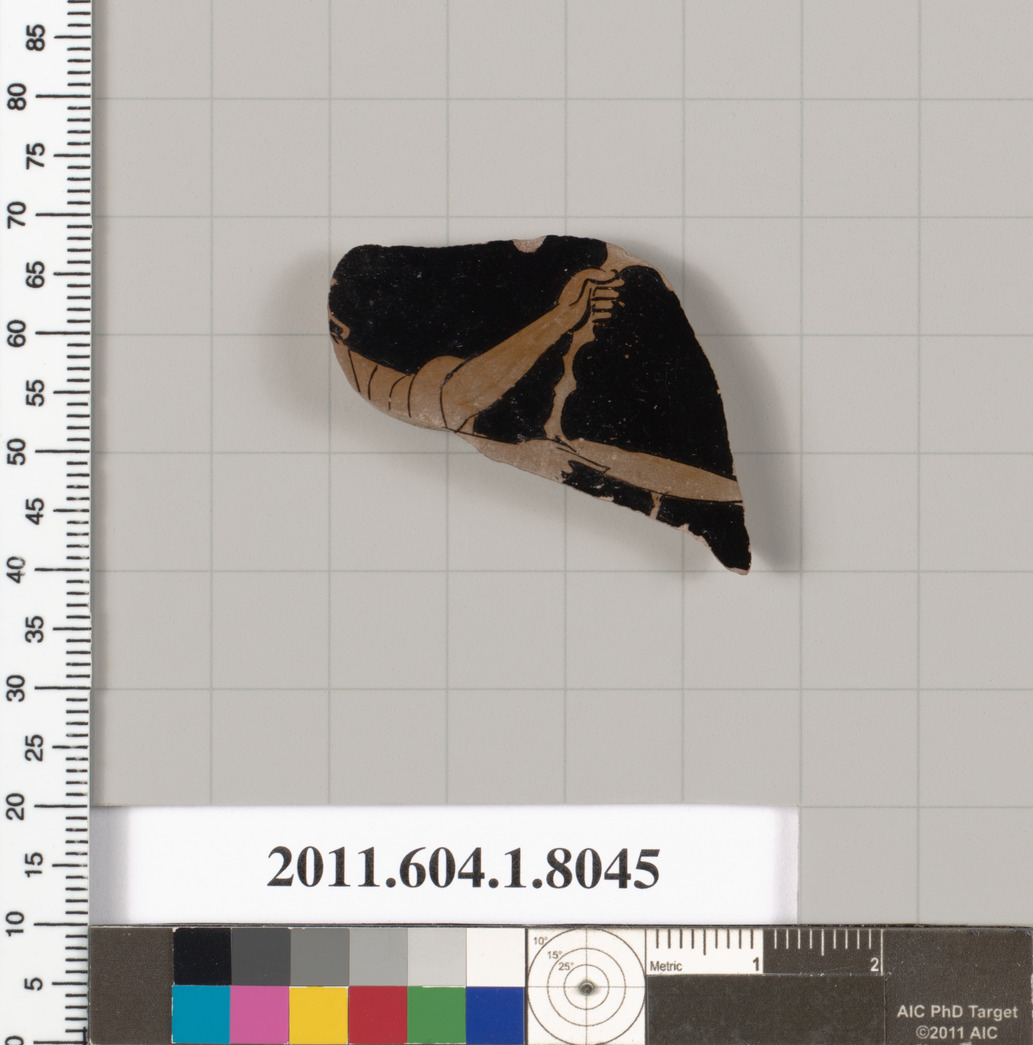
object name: kylix fragment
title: Terracotta fragment of a kylix (drinking cup)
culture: greek, attic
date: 510-490 BCE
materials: terracotta